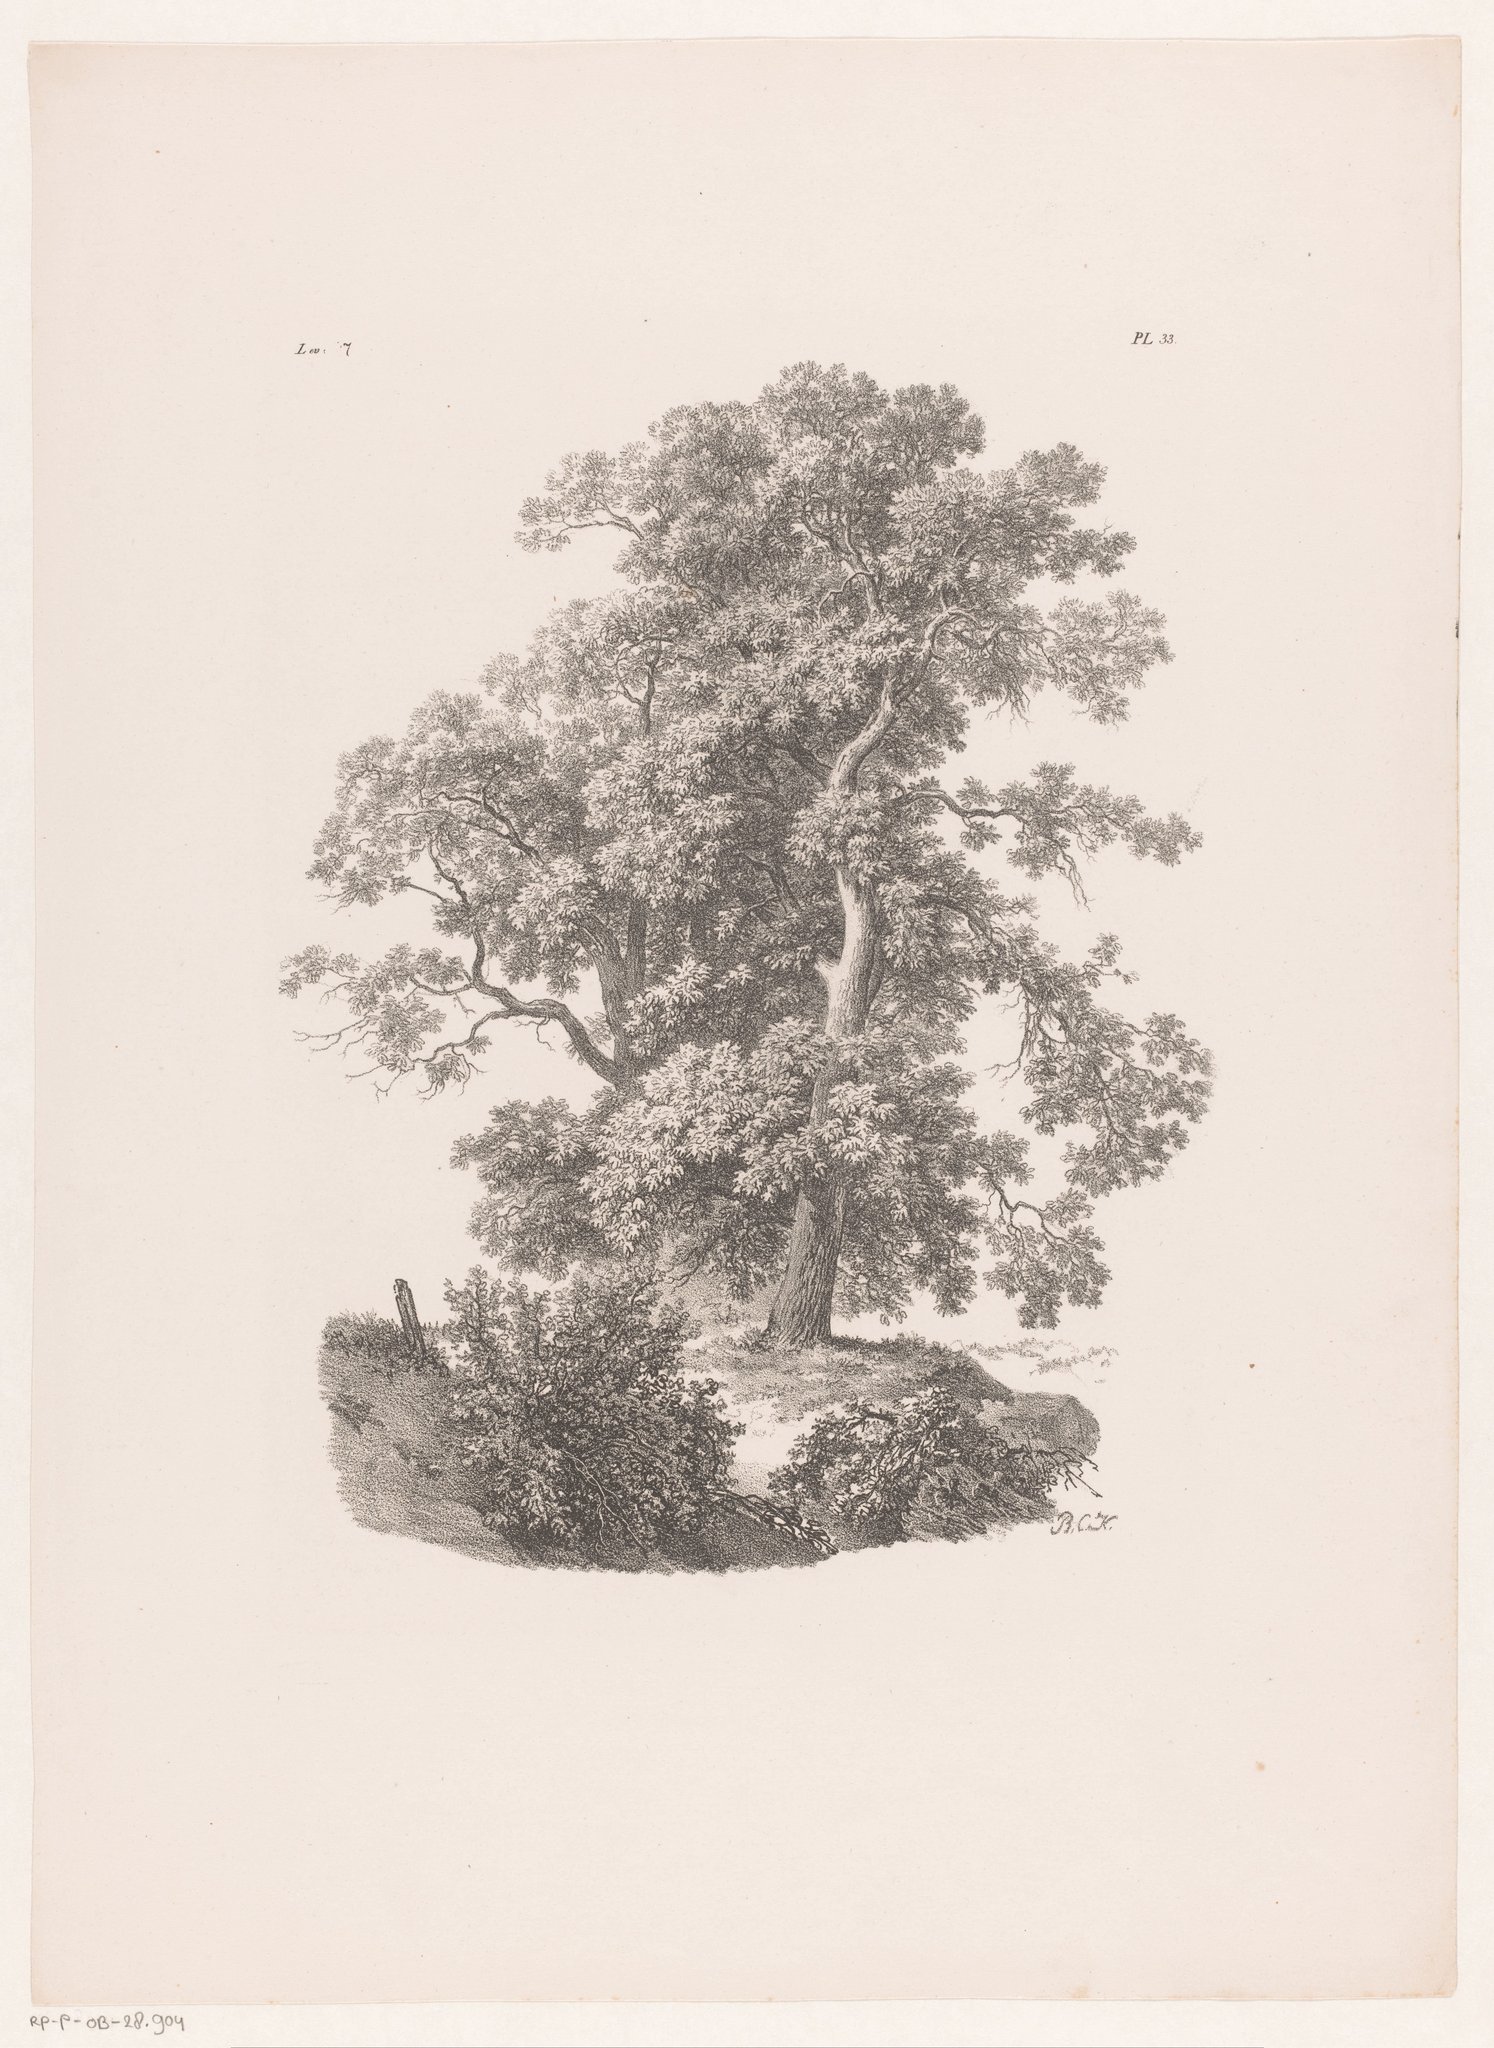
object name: print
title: Twee bomen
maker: barend cornelis koekkoek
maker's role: draughtsman, painter, print maker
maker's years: 1803-1862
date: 1829-1845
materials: paper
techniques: lithograph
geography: amsterdam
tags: groups of trees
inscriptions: collector's mark: Lugt 2228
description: Links in de voorgrond staat een paal. Genummerd links- en rechtsboven: 'Lev. 7' en 'PL 33'.